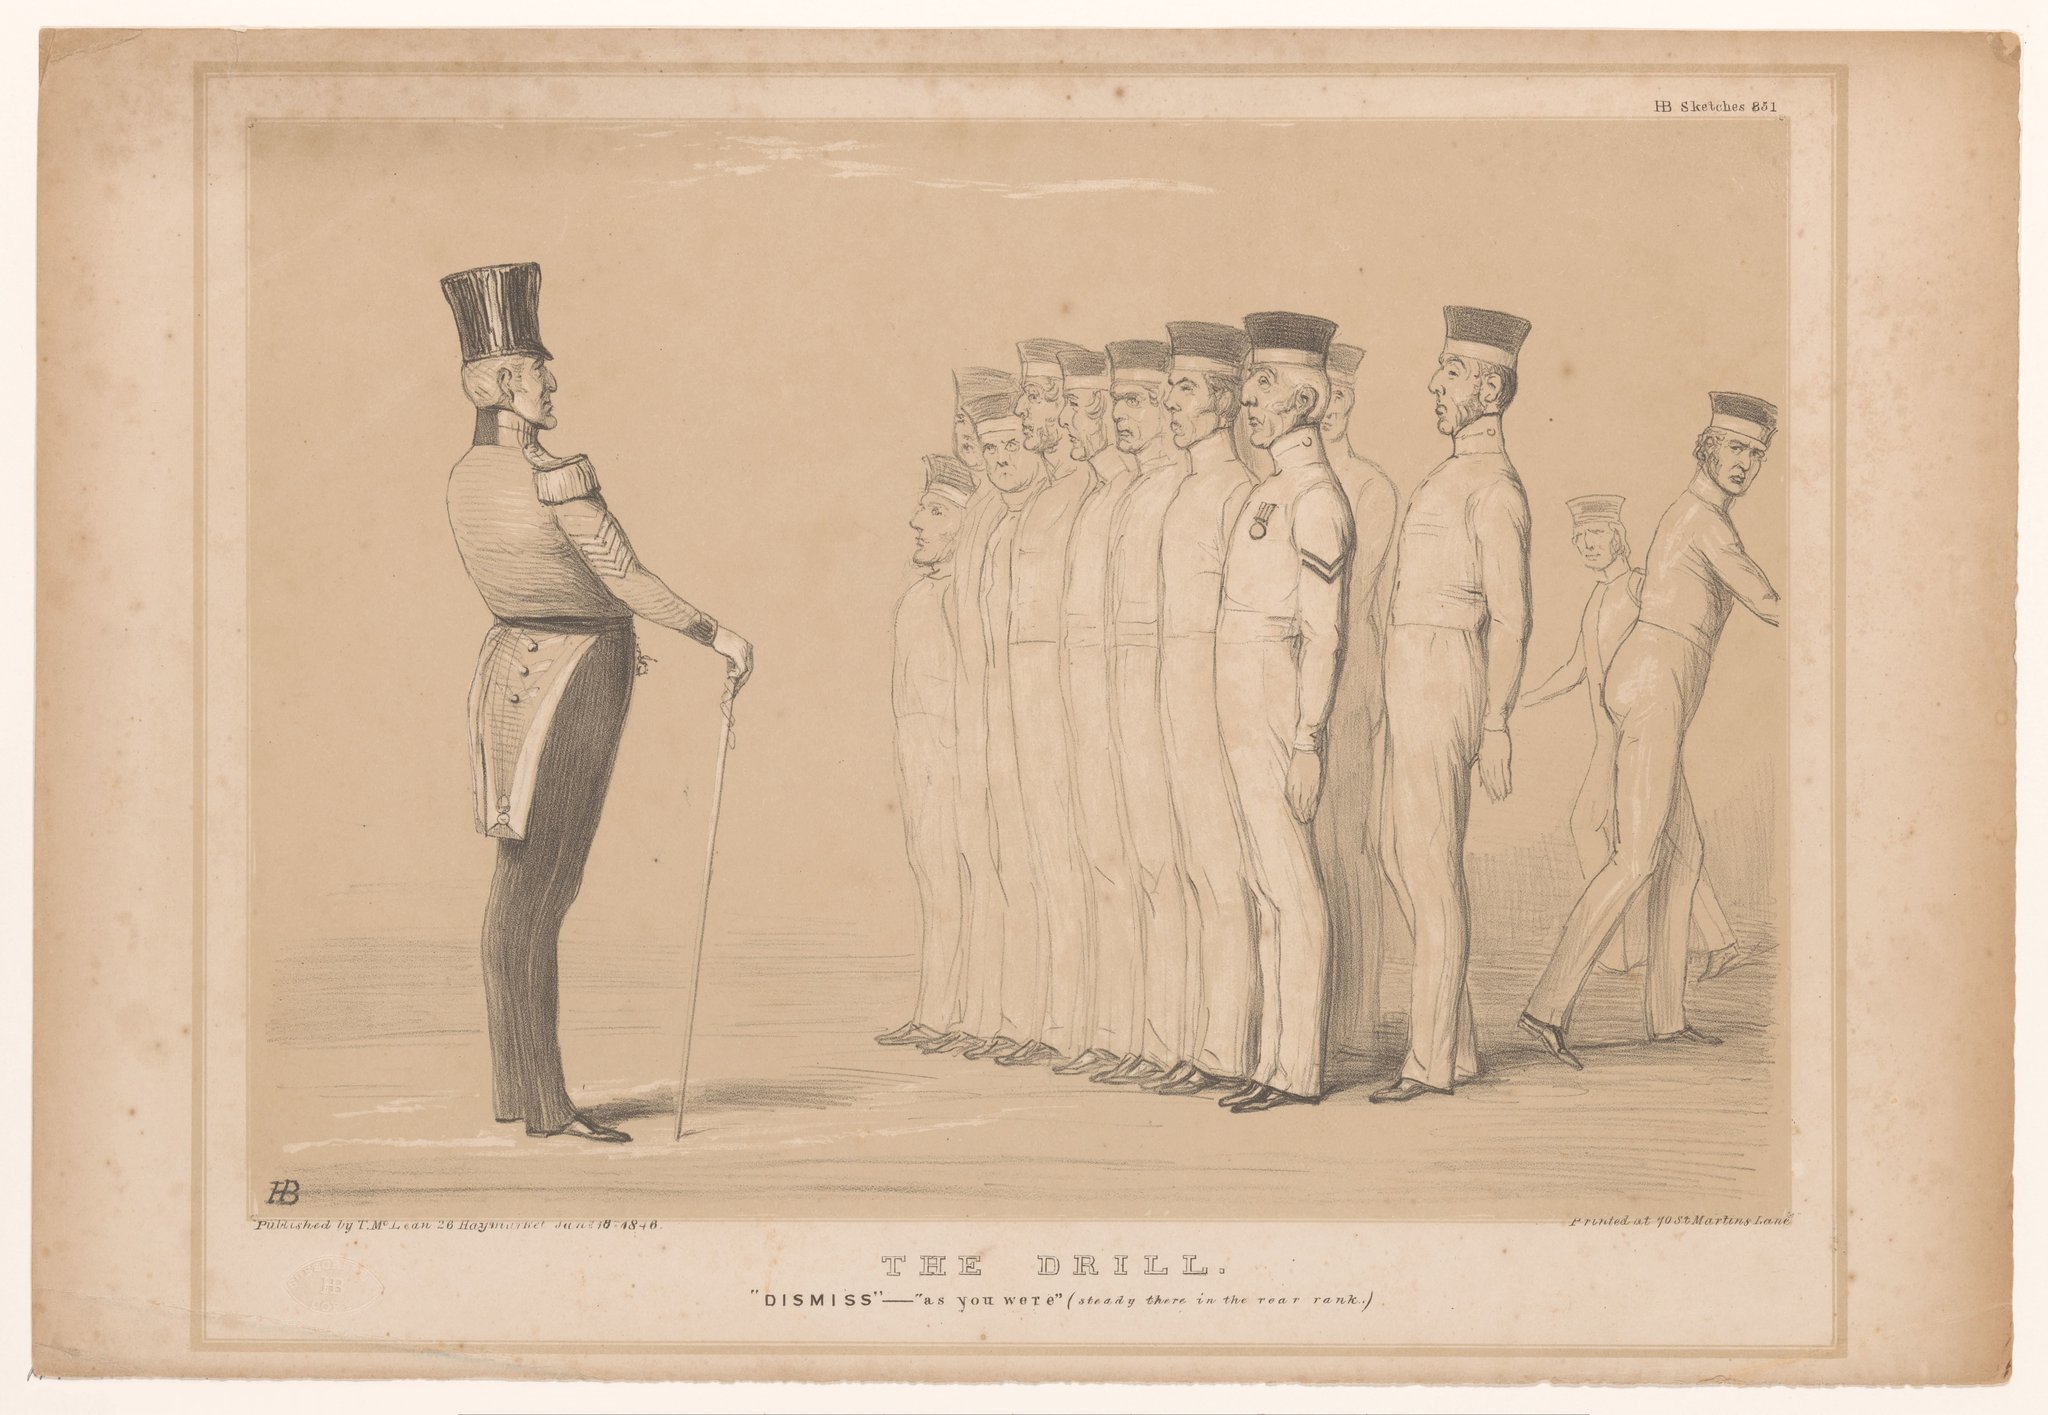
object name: cartoon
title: HB Sketches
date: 1846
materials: paper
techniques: tone lithography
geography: london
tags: london, drill ~ military training, political caricatures and satires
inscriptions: stamp: ‘HB Subscribers Copy’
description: Spotprent uit 1846 waarin premier Robert Peel een militaire exercitie leidt. Uitgegeven als nr. 851 in de serie HB Sketches.